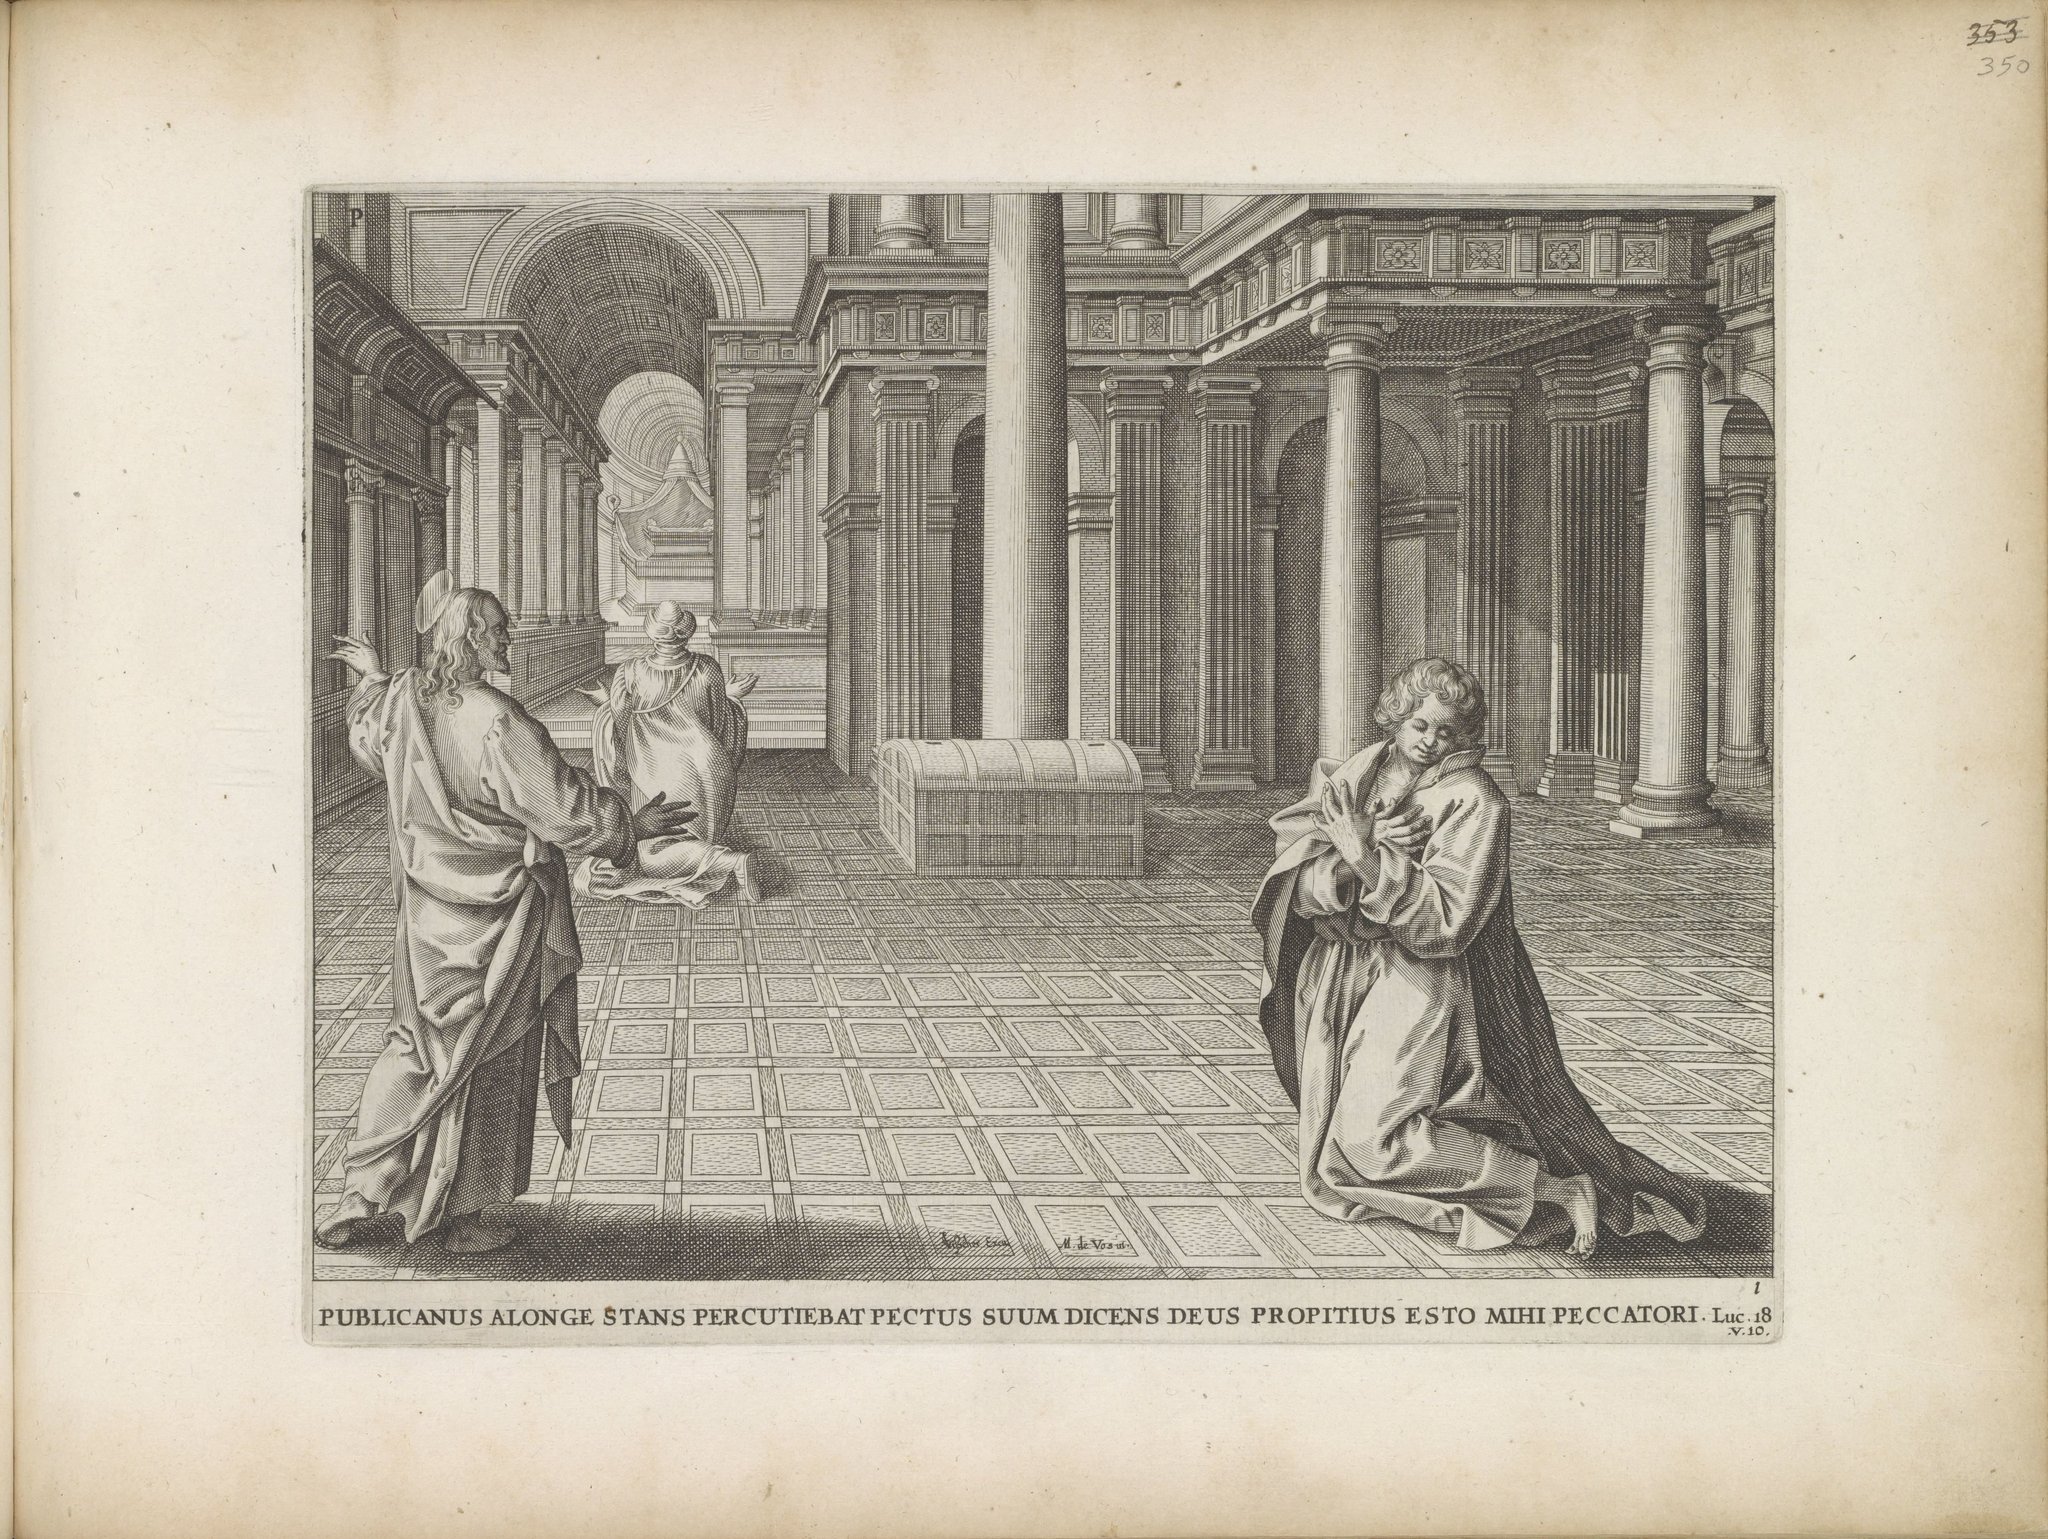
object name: album leaf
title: Theatrum Biblicum Hoc Est Historiae Sacrae Veteris et Novi Testamenti Tabulis Aeneis Expressae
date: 1643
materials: paper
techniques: engraving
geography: amsterdam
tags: the praying pharisee and the repentant publican in the temple (luke 18:10-14)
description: Christus, staande links, vertelt de gelijkenis van de farizeeër en de tollenaar. Rechts knielt de tollenaar berouwvol in de tempel en vraagt God om genade. Bij het altaar op de achtergrond bidt de farizeeër, die God dankt dat hij niet is zoals de tollenaar. Onder de voorstelling een verwijzing in het Latijn naar de Bijbeltekst in Luc. 18:10. Deze prent maakt deel uit van een album.